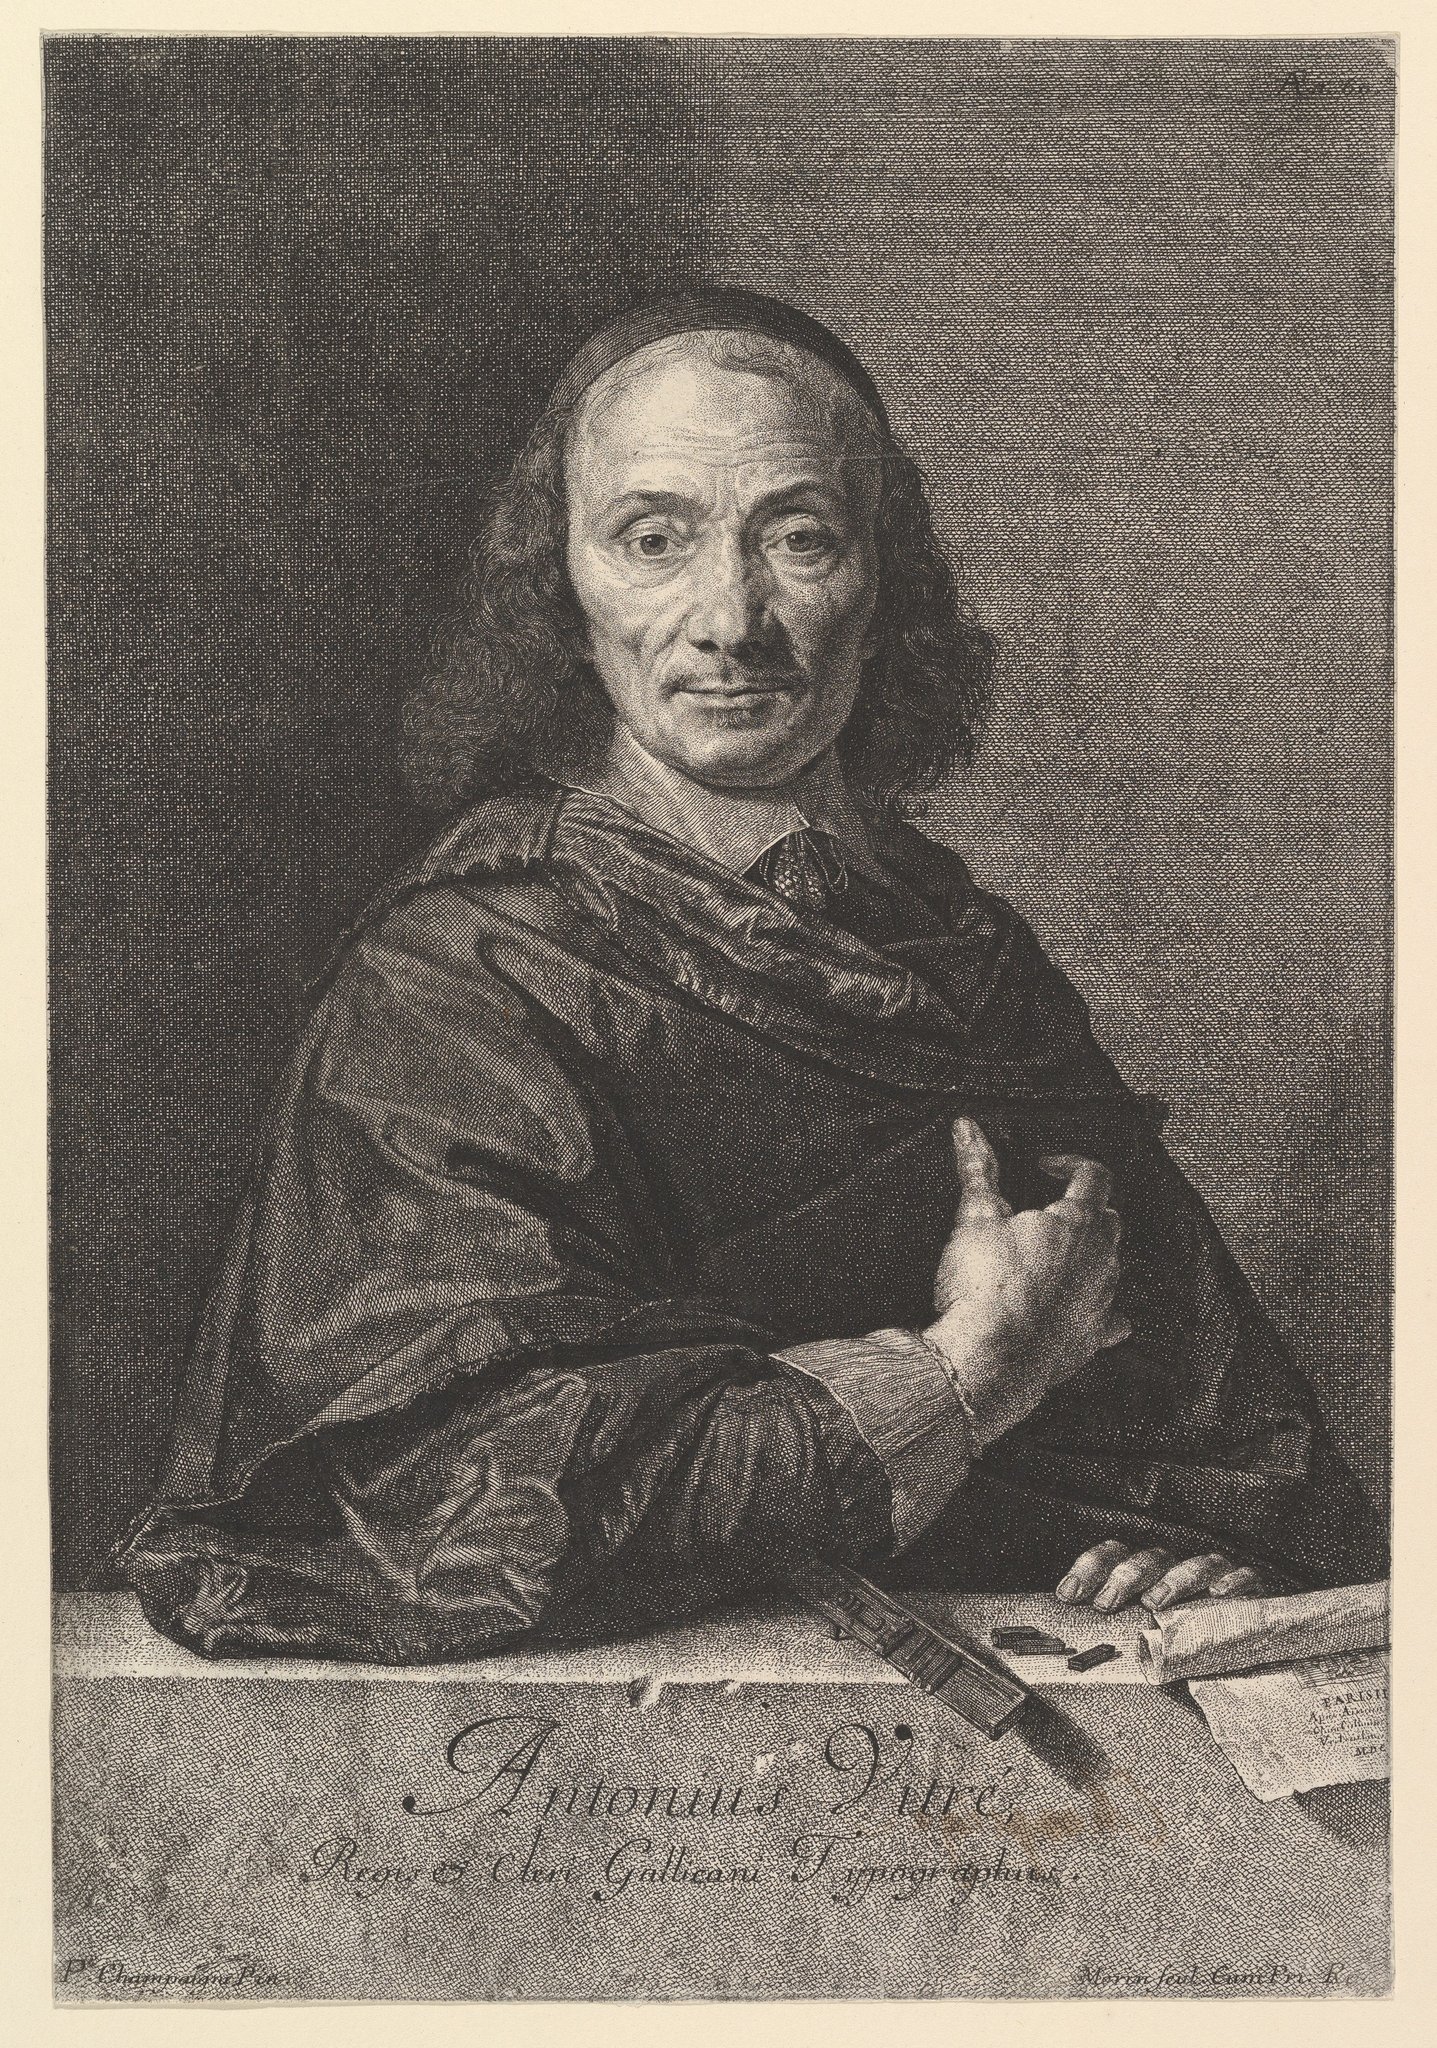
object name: print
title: Antoine Vitre, typographe du roi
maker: jean morin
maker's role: artist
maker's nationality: french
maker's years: 1605-1650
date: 1605-1650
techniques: etching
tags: men,portraits